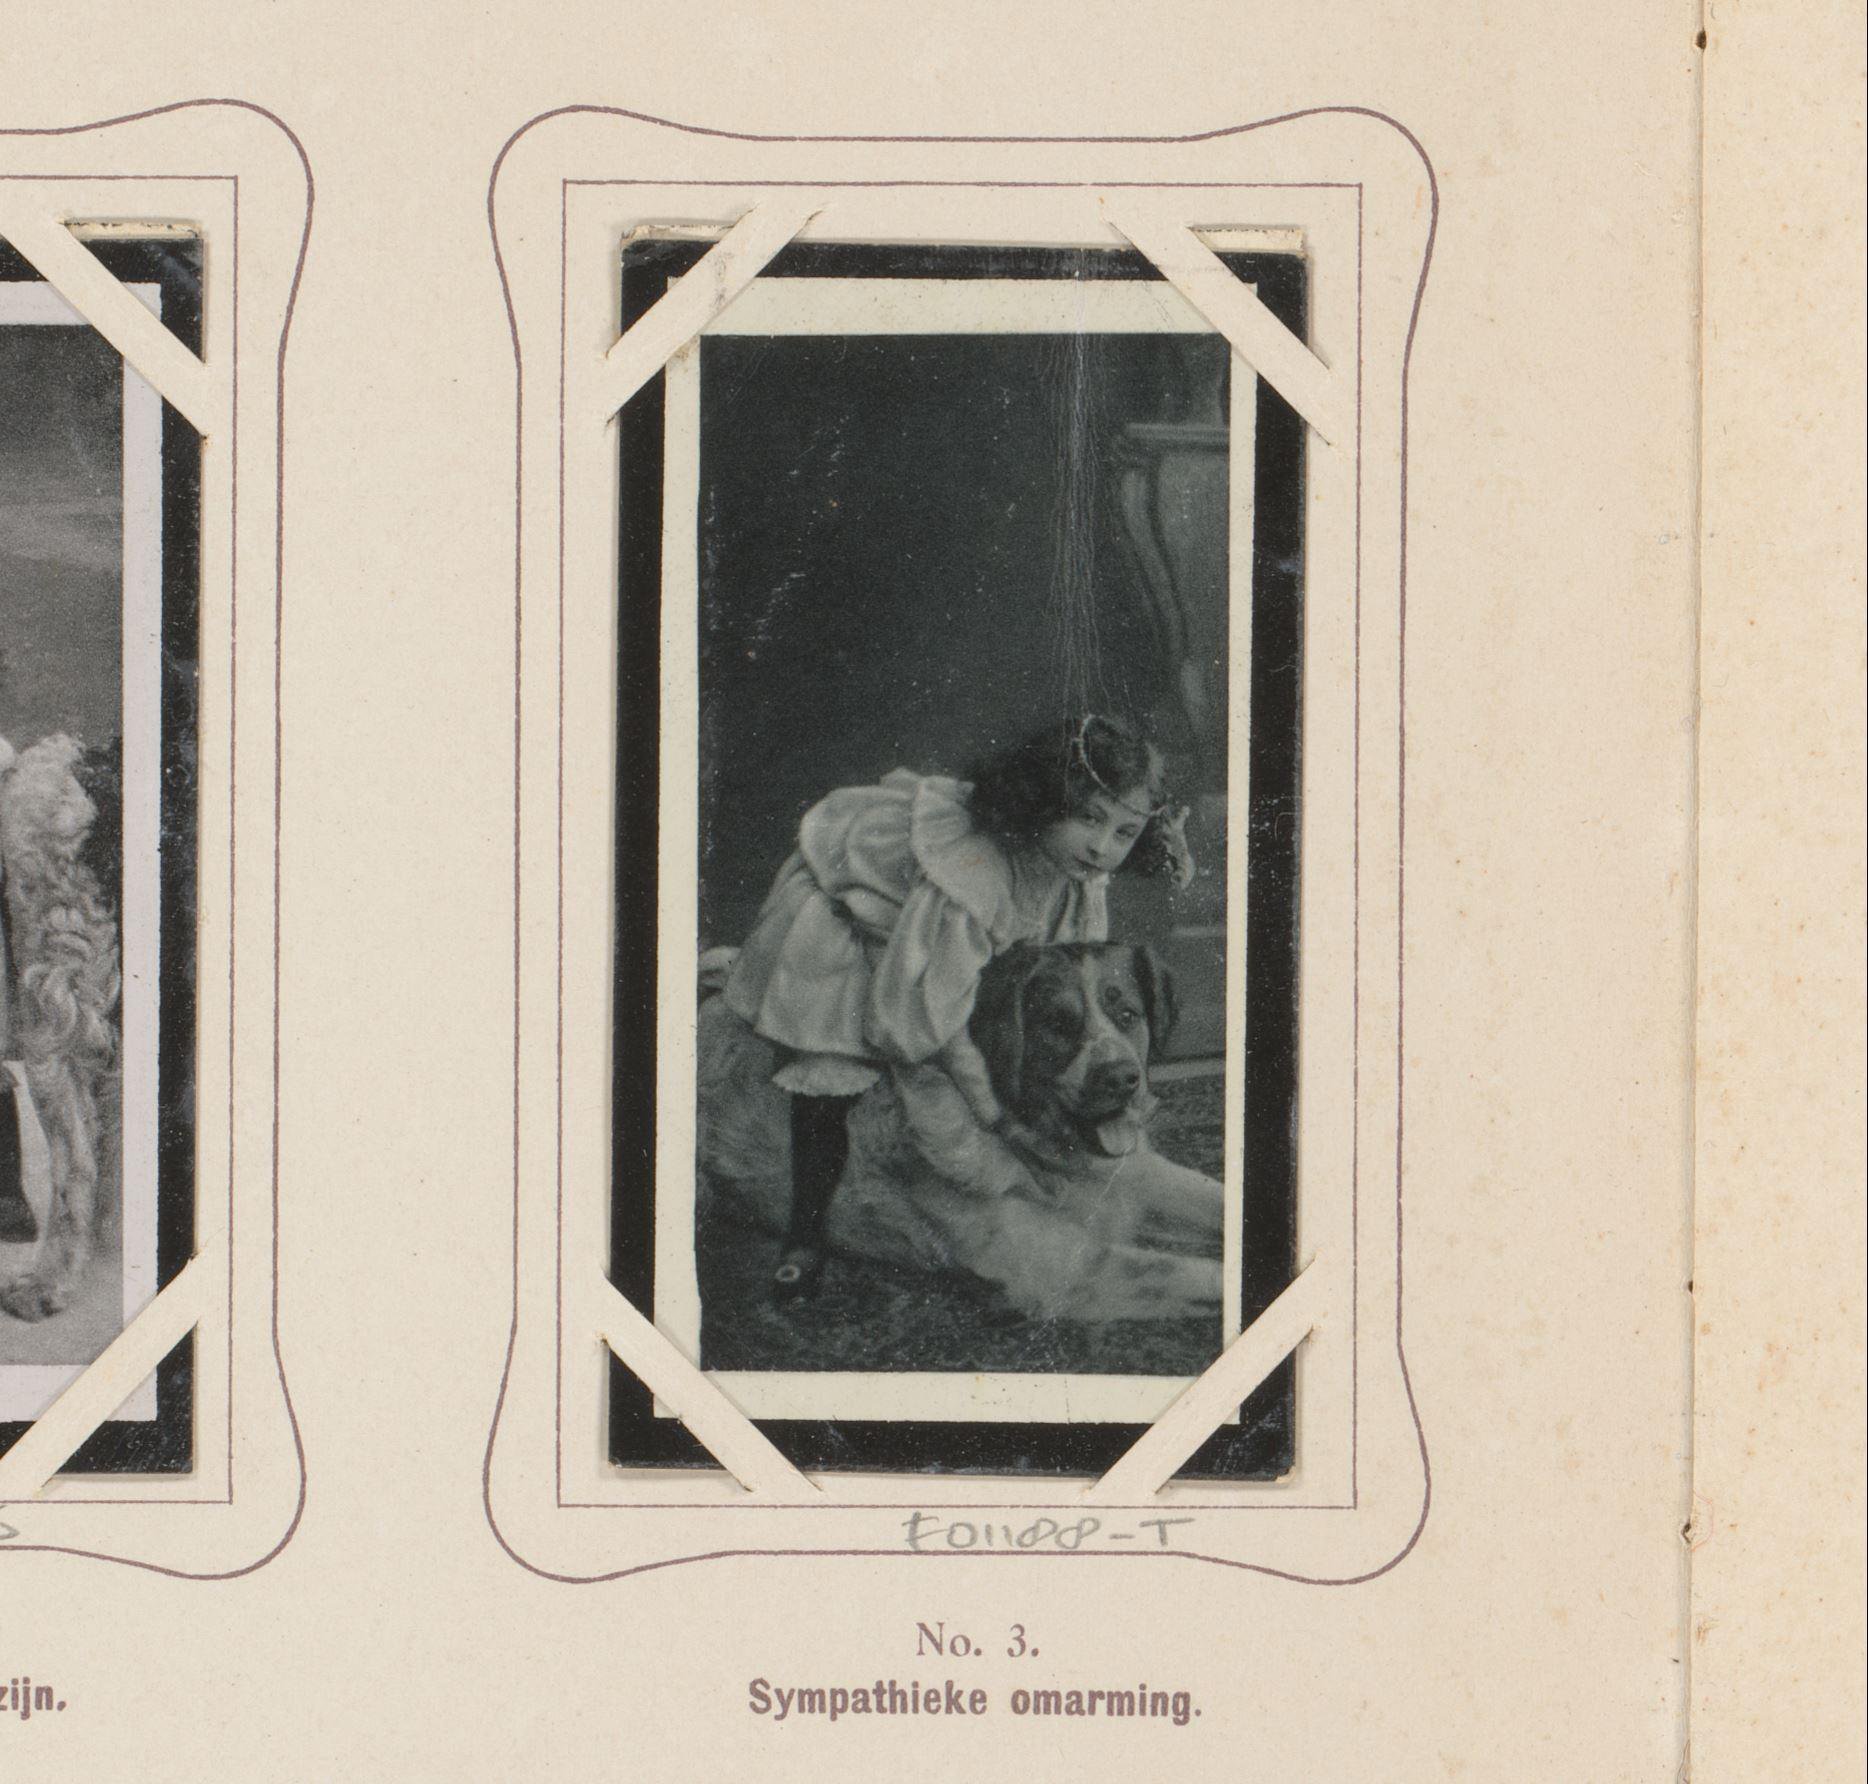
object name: album leaf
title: Meisje met hond in fotostudio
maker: Anonymous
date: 1906-1907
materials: paper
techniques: photograph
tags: studio ~ photographer, girl (child between toddler and youth), dog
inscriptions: inscription: ‘No. 3./ Sympathieke omarming.’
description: Deze prent maakt deel uit van een album.